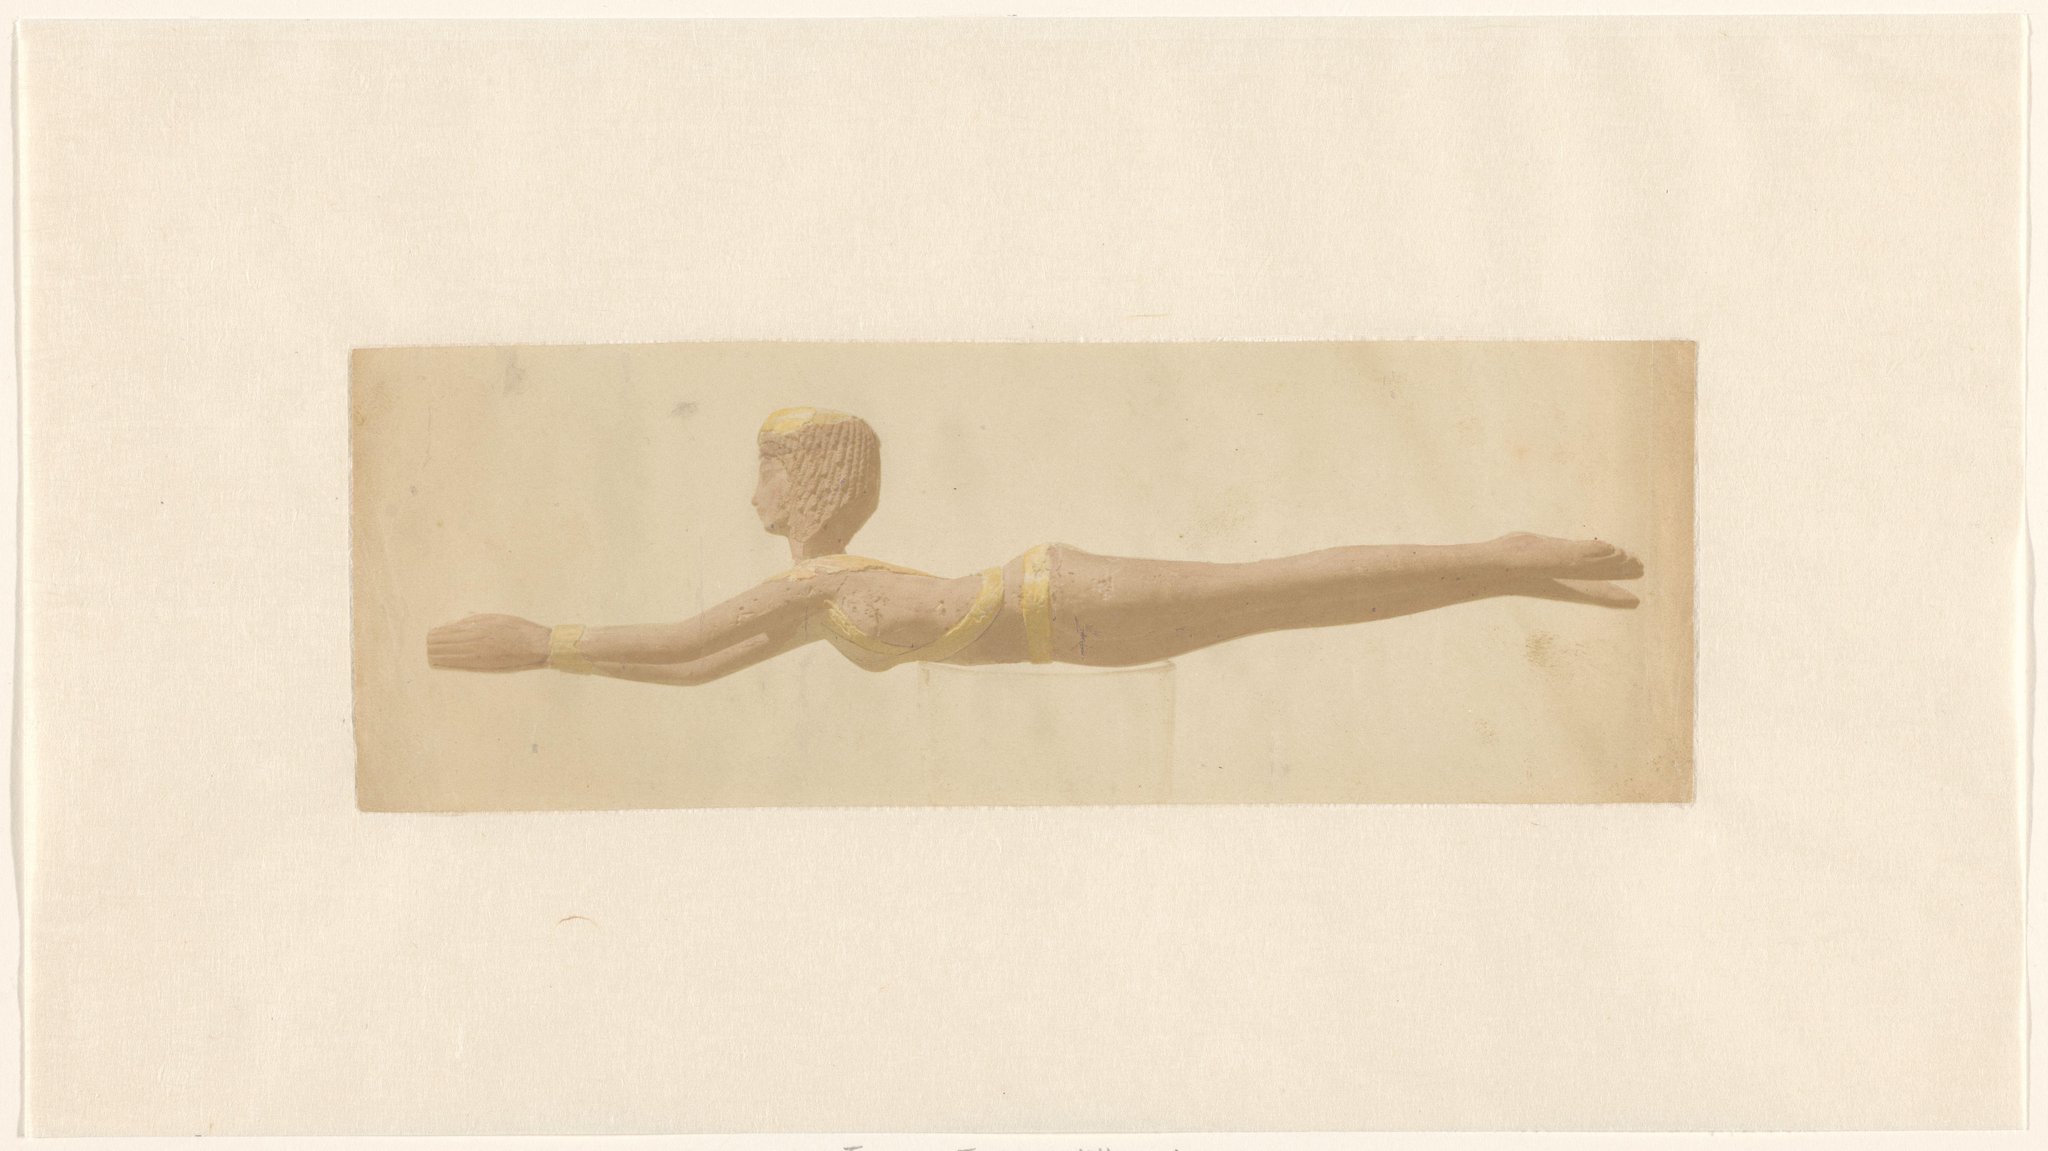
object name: photograph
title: De gebeeldhouwde houten steel van een oud Egyptische lepel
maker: willem de famars testas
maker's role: draughtsman, painter, print maker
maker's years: 1834-1896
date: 1858-1860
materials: paint, photographic support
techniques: salted paper print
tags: spoon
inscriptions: inscription: ‘Manche de cuillère en bois. Ancien Egyptien’, inscription: ‘1082/7 (M v W)’